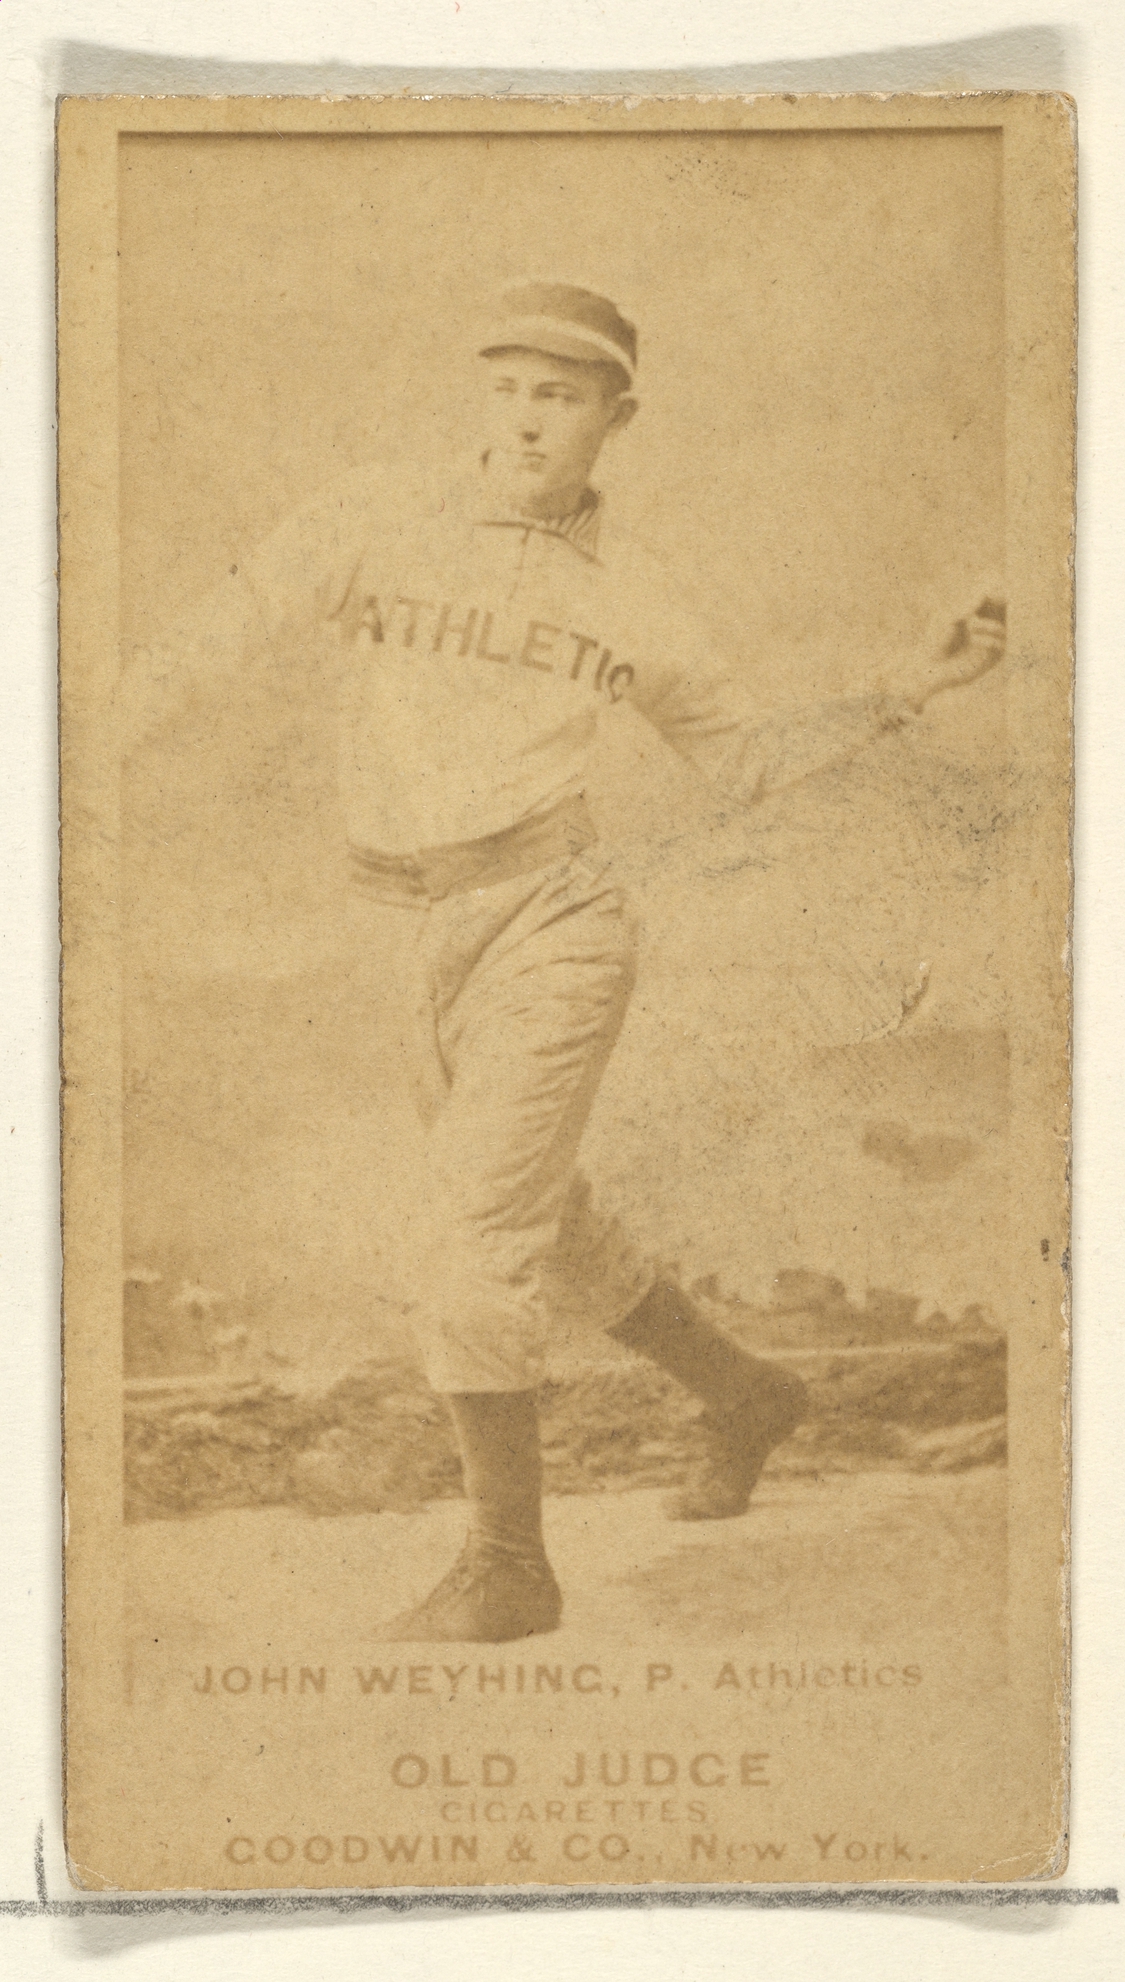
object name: baseball card, photograph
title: John Weyhing, Pitcher, Philadelphia Athletics, from the Old Judge series (N172) for Old Judge Cigarettes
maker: goodwin & company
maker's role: publisher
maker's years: 1850-1950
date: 1887-1890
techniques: albumen silver print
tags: men,portraits,baseball,athletes